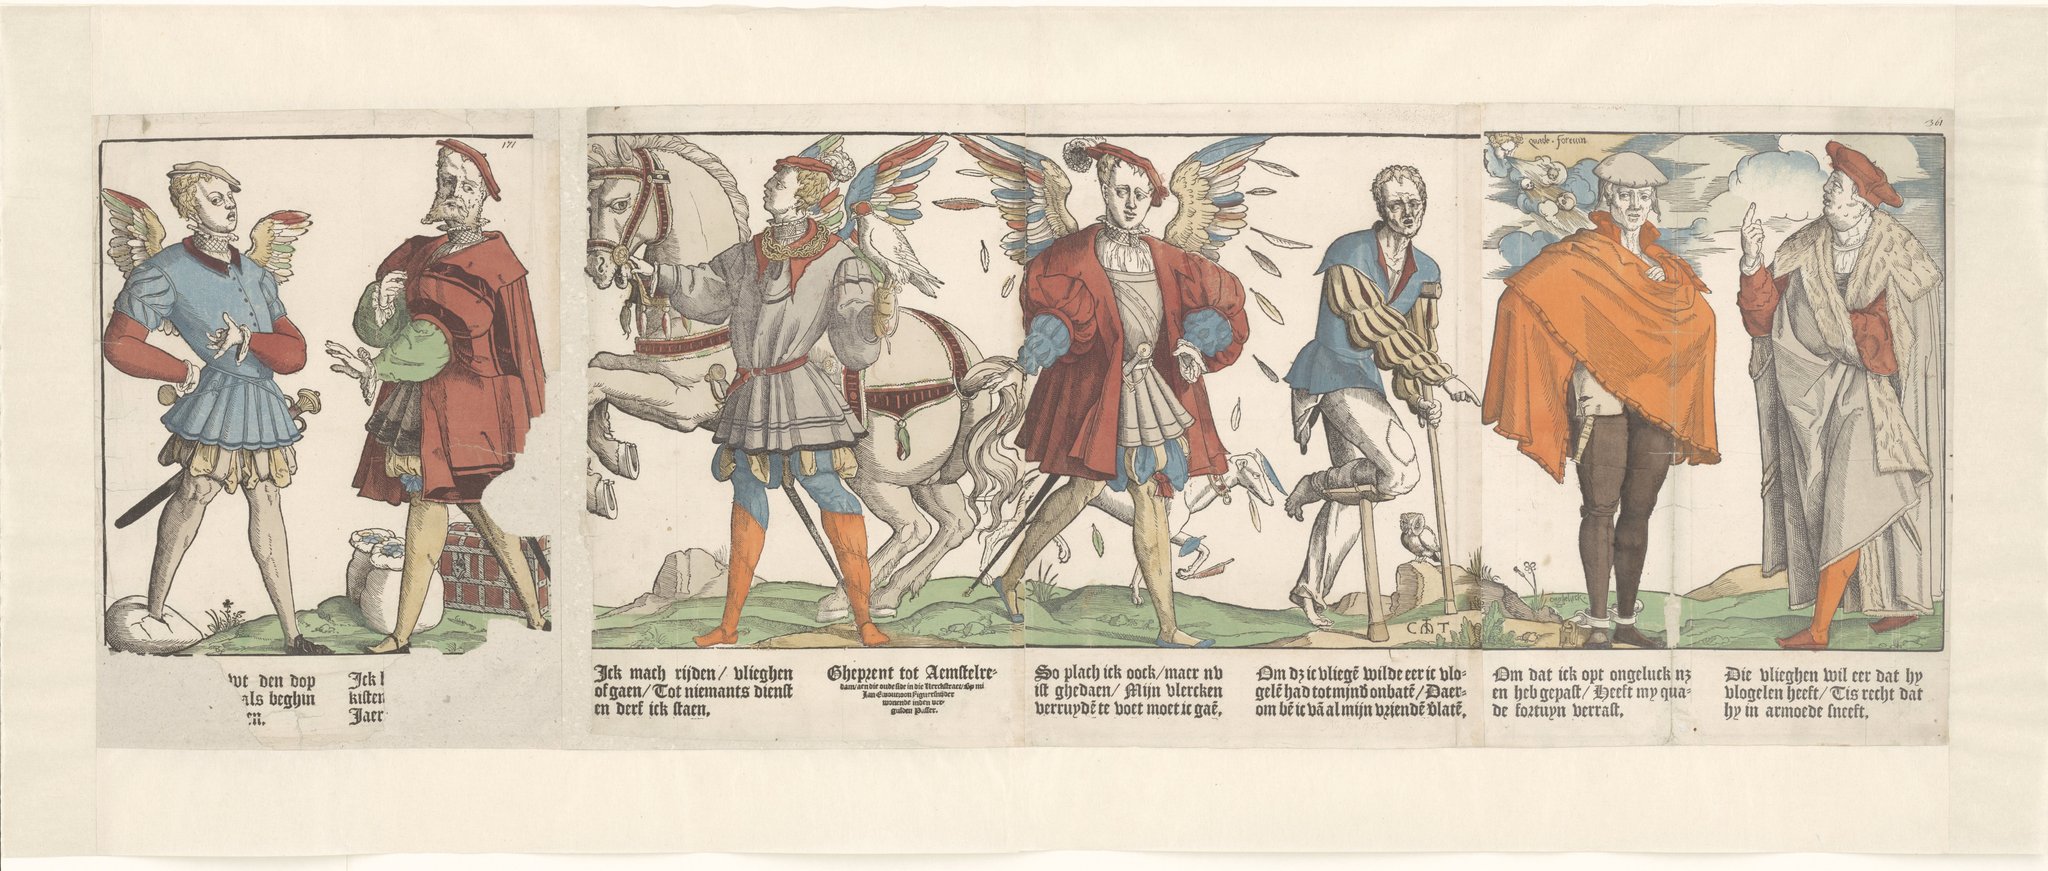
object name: print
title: De vliegende jeugd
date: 1509-1553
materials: paper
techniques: brush, hand coloring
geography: amsterdam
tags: youth, adolescence, 'iuventus'; 'adolescenza', 'gioventù' (ripa)